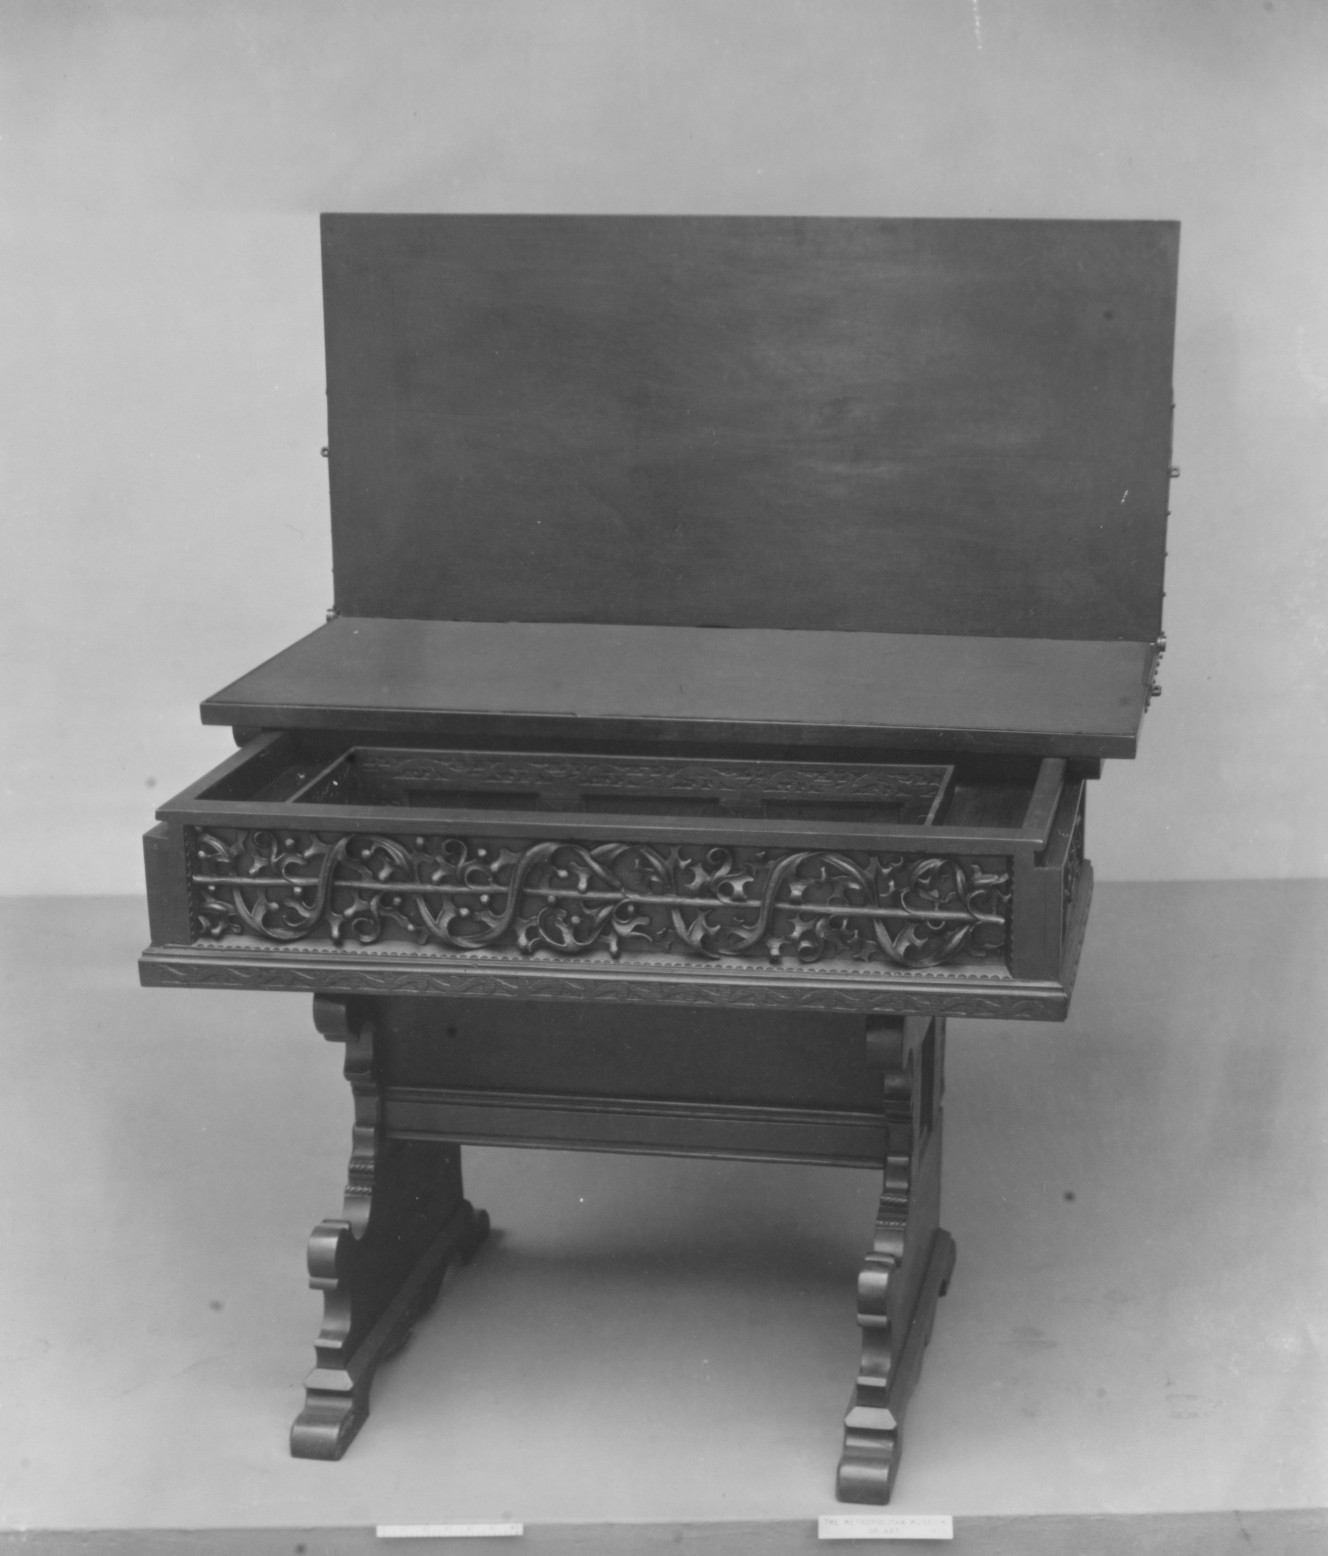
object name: table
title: Money-Changer's Table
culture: german, south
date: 1401-1600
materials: wood